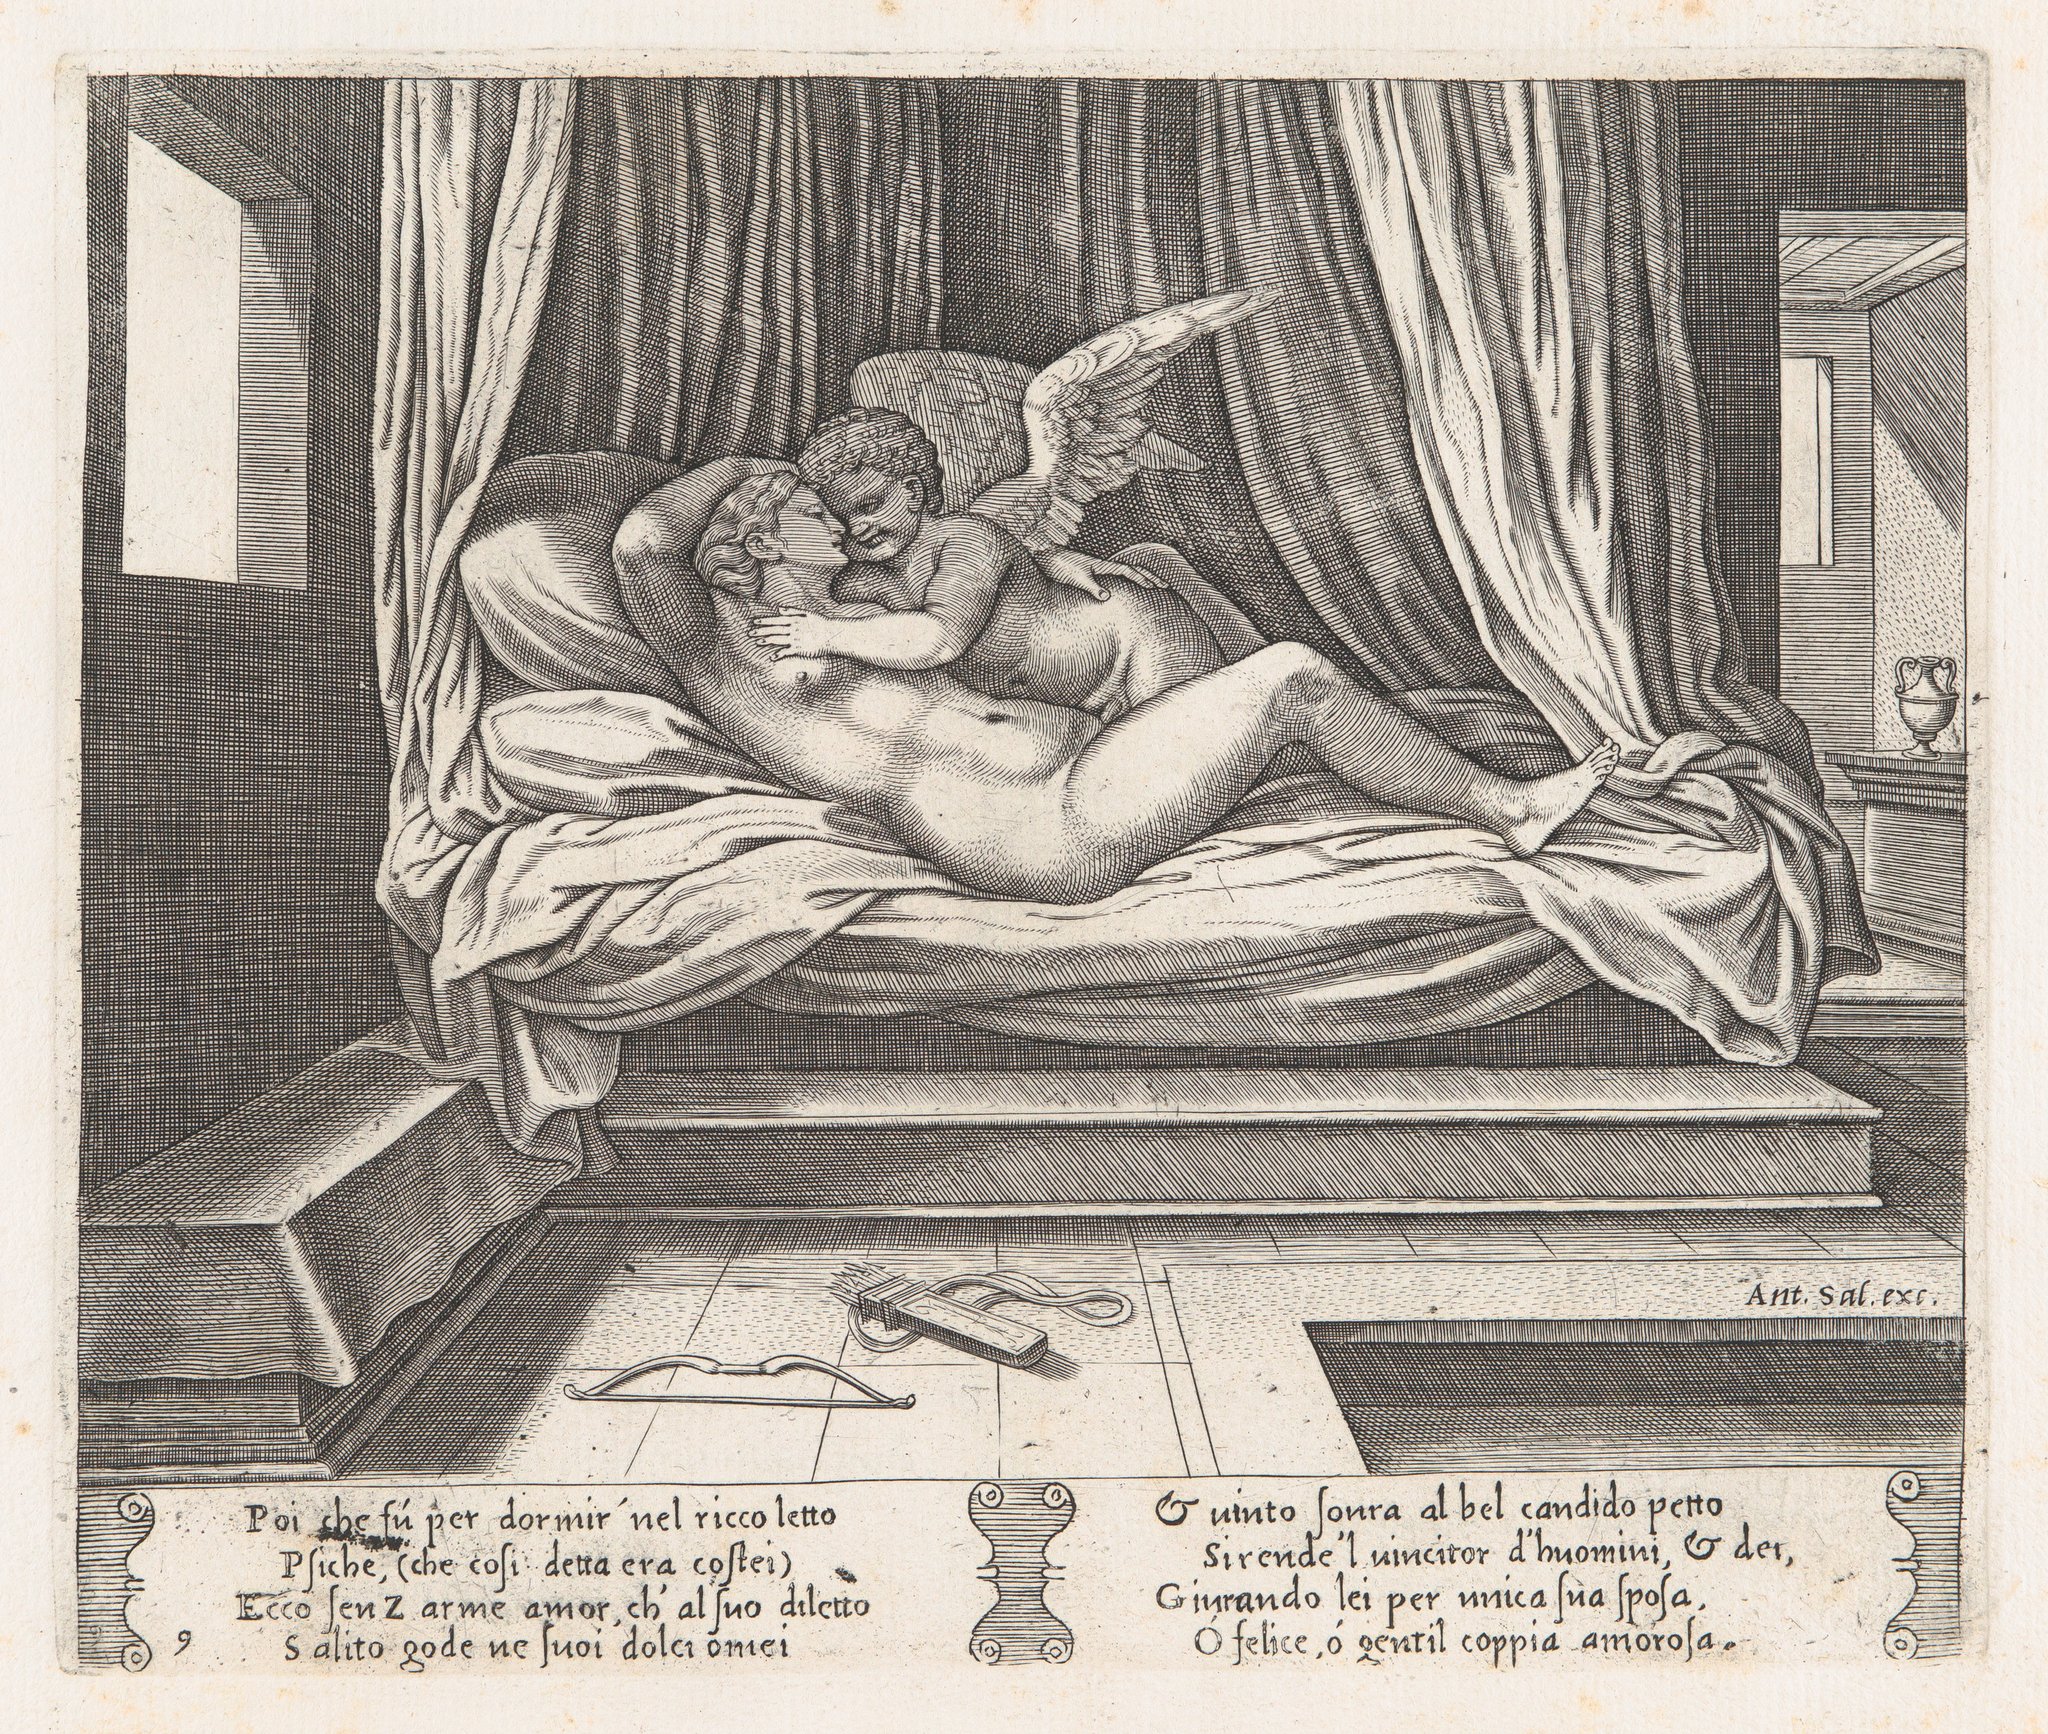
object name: print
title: Plate 9: Cupid and Psyche on a bed, from "The Story of Cupid and Psyche as told by Apuleius"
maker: master of the die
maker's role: artist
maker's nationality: italian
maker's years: 1525-1560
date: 1530-1560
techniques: engraving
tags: cupid,psyche,beds